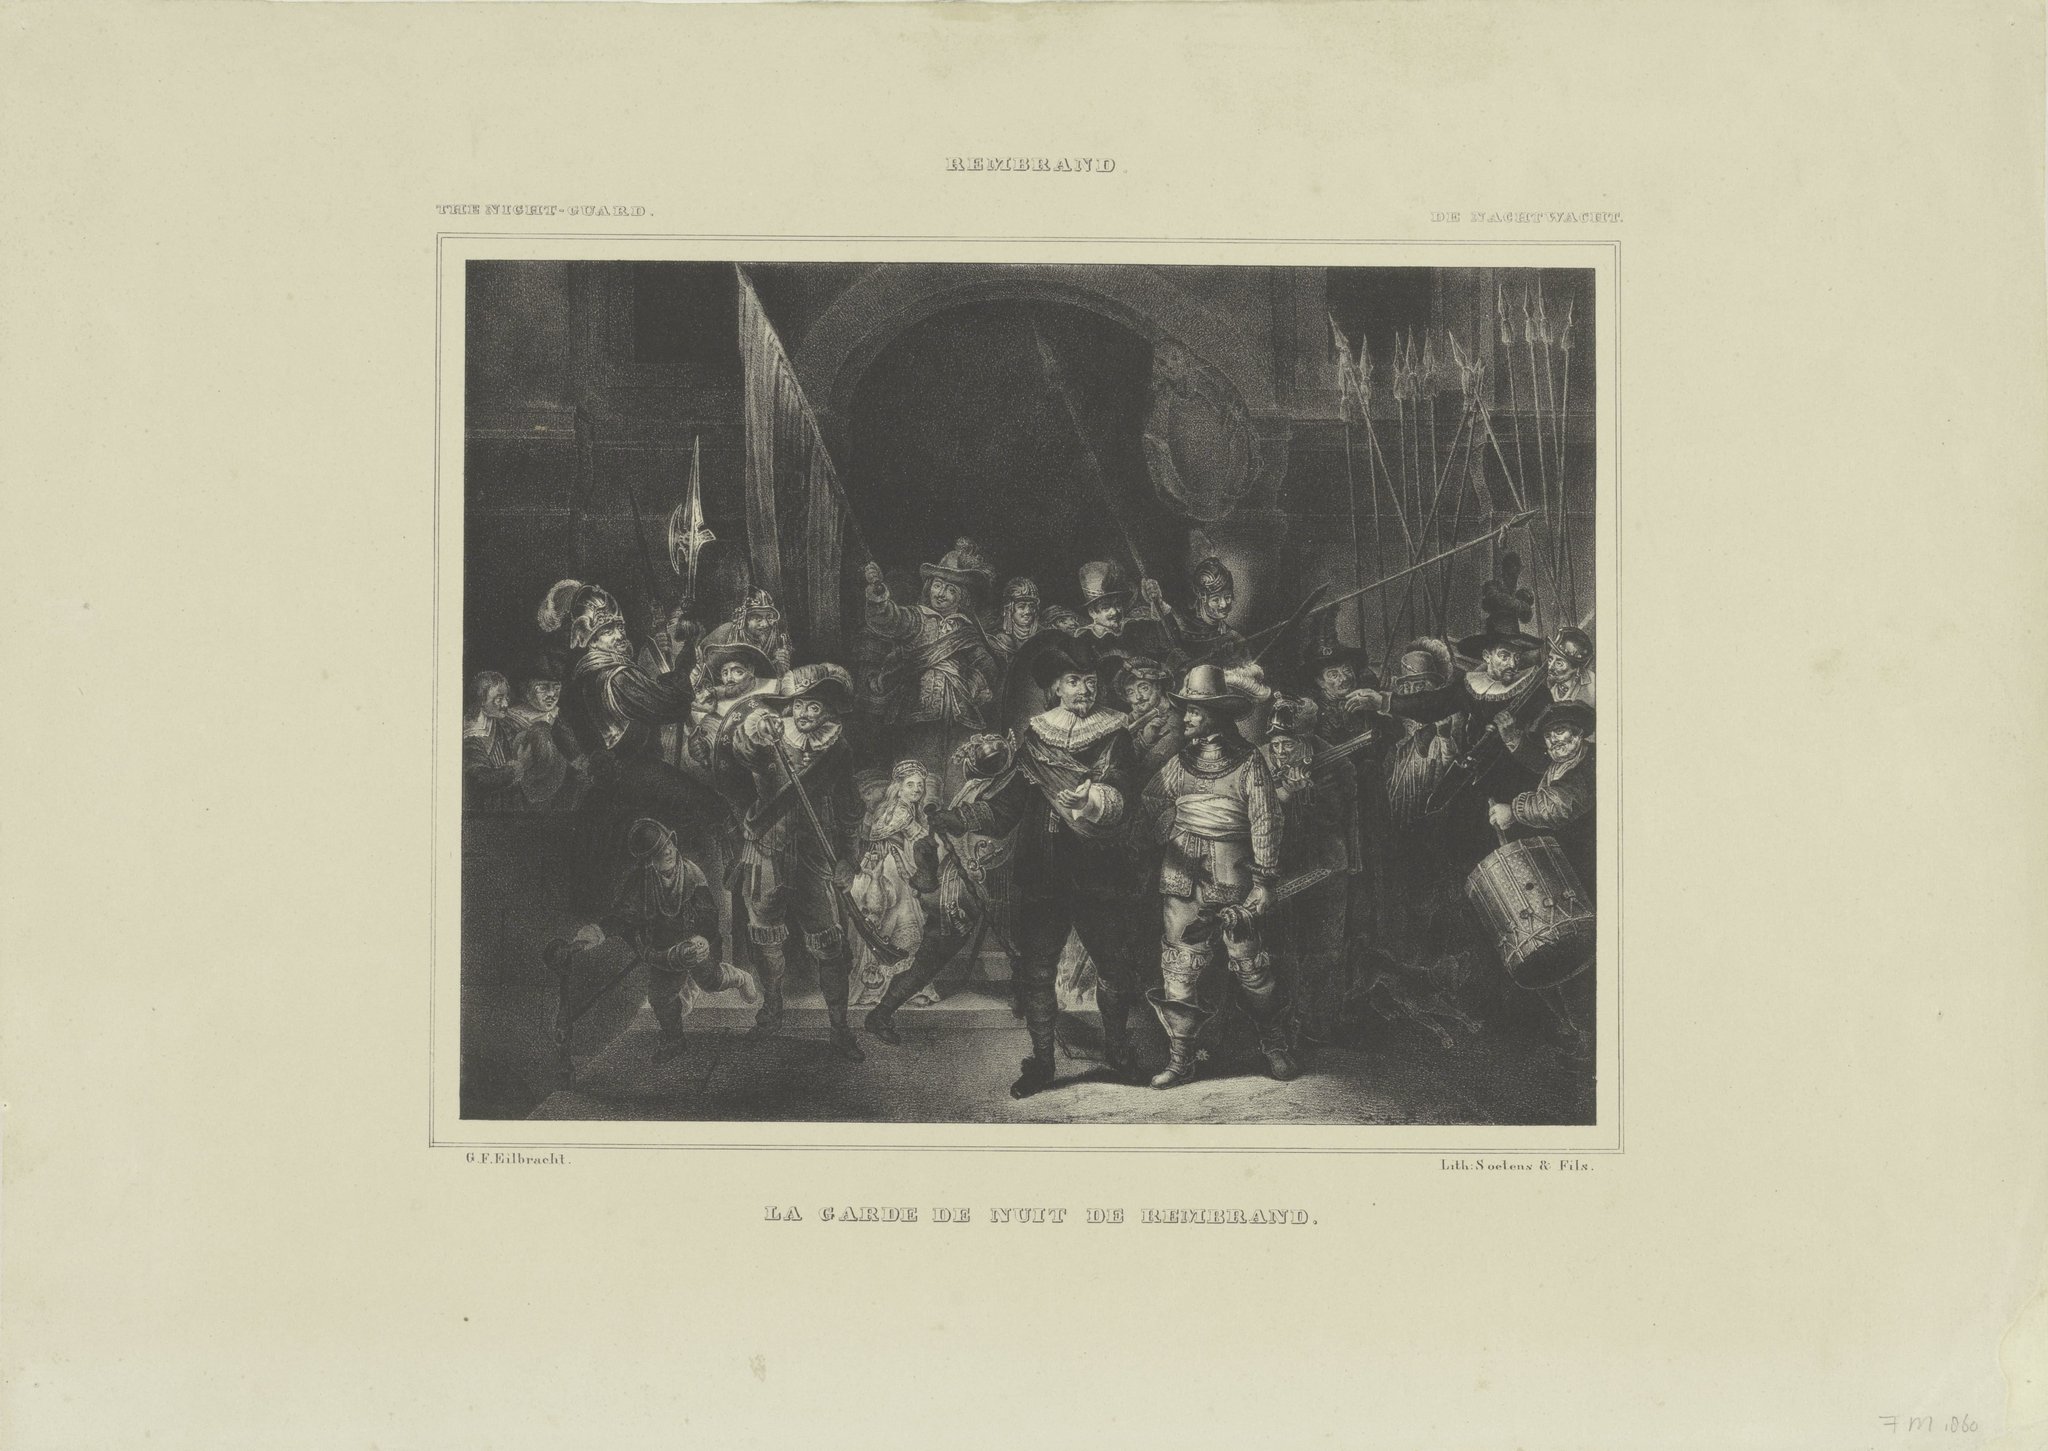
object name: print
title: Officieren en andere schutters van wijk II in Amsterdam onder leiding van kapitein Frans Banninck Cocq en luitenant Willem van Ruytenburch, bekend als de ‘Nachtwacht’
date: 1837-1840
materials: paper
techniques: lithograph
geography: amsterdam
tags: (military) standard-bearer, girl (child between toddler and youth), drum (musical instrument), weapons, warfare; military affairs (+ citizen soldiery, civil guard, citizen militia)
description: Het korporaalschap van kapitein Frans Banninck Cocq en luitenant Willem van Ruytenburch, bekend als de 'Nachtwacht'. De schutters van de kloveniersdoelen komen door een poort naar buiten. De schutters zijn gewapend met lansen, musketten en hellebaarden. Rechts de tamboer met een grote trommel. Tussen de soldaten links staat een meisje met een dode kip om haar middel, rechts een blaffende hond. Linksboven de vaandrig met de uitgestoken vaandel. Naar een schilderij door Rembrandt Harmensz. van Rijn in het Rijks Museum Amsterdam.